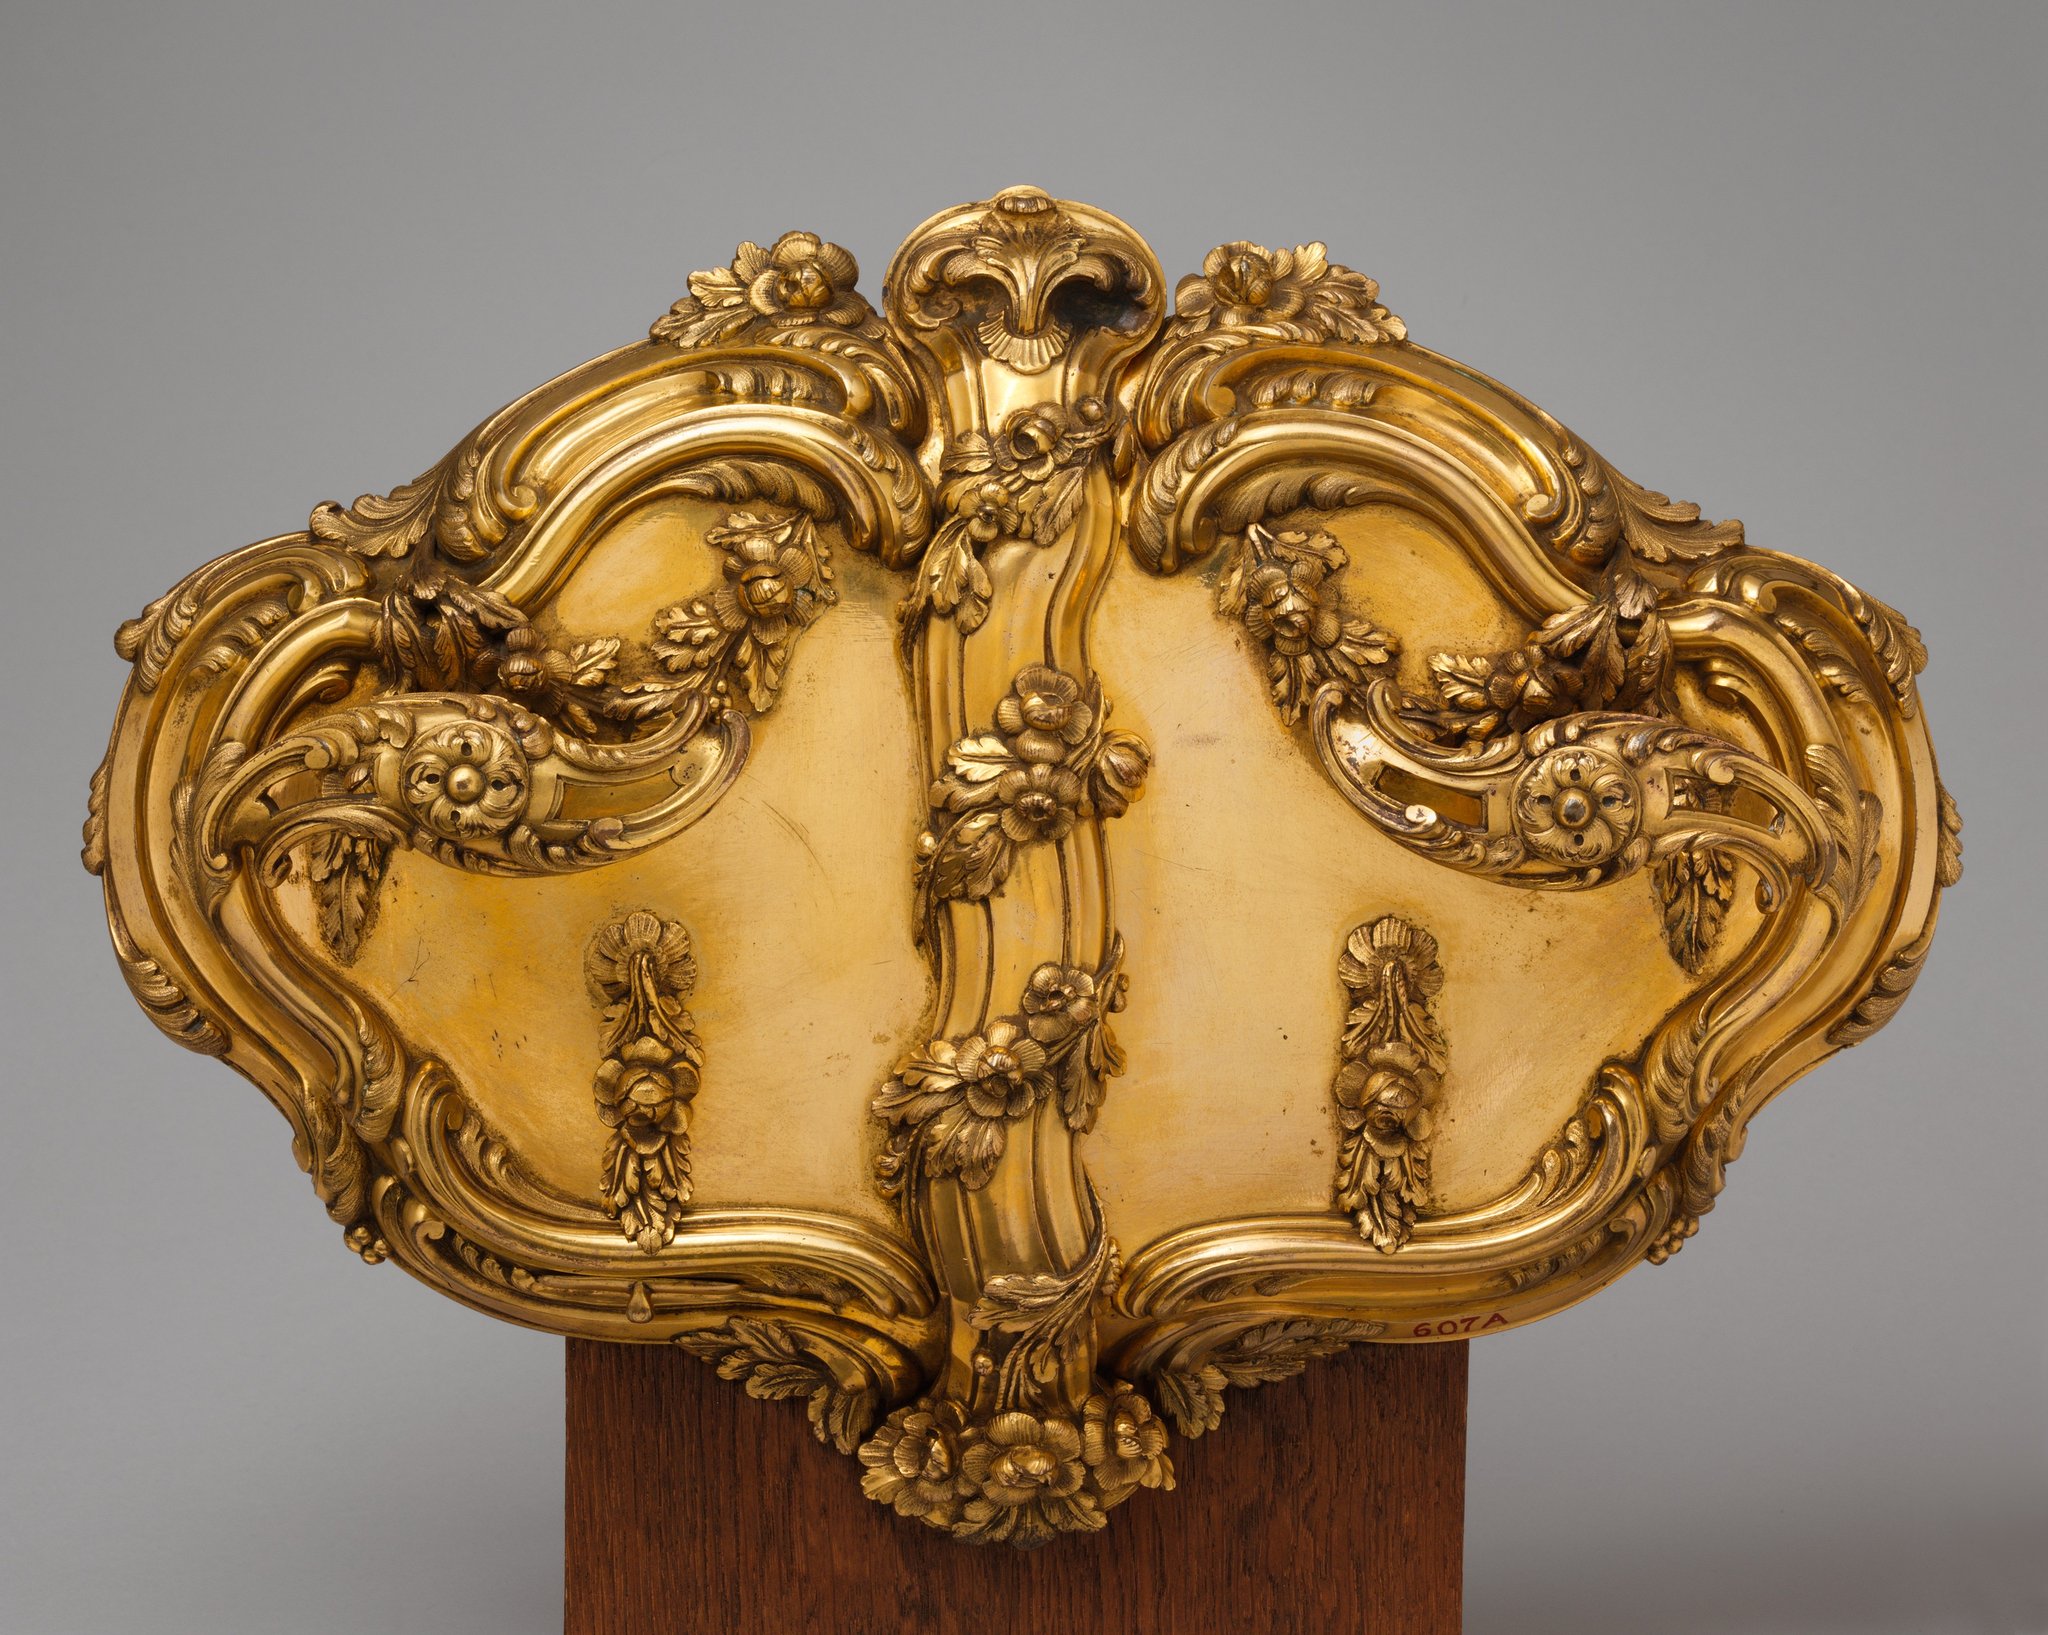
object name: door lock and key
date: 1770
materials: gilt bronze, steel